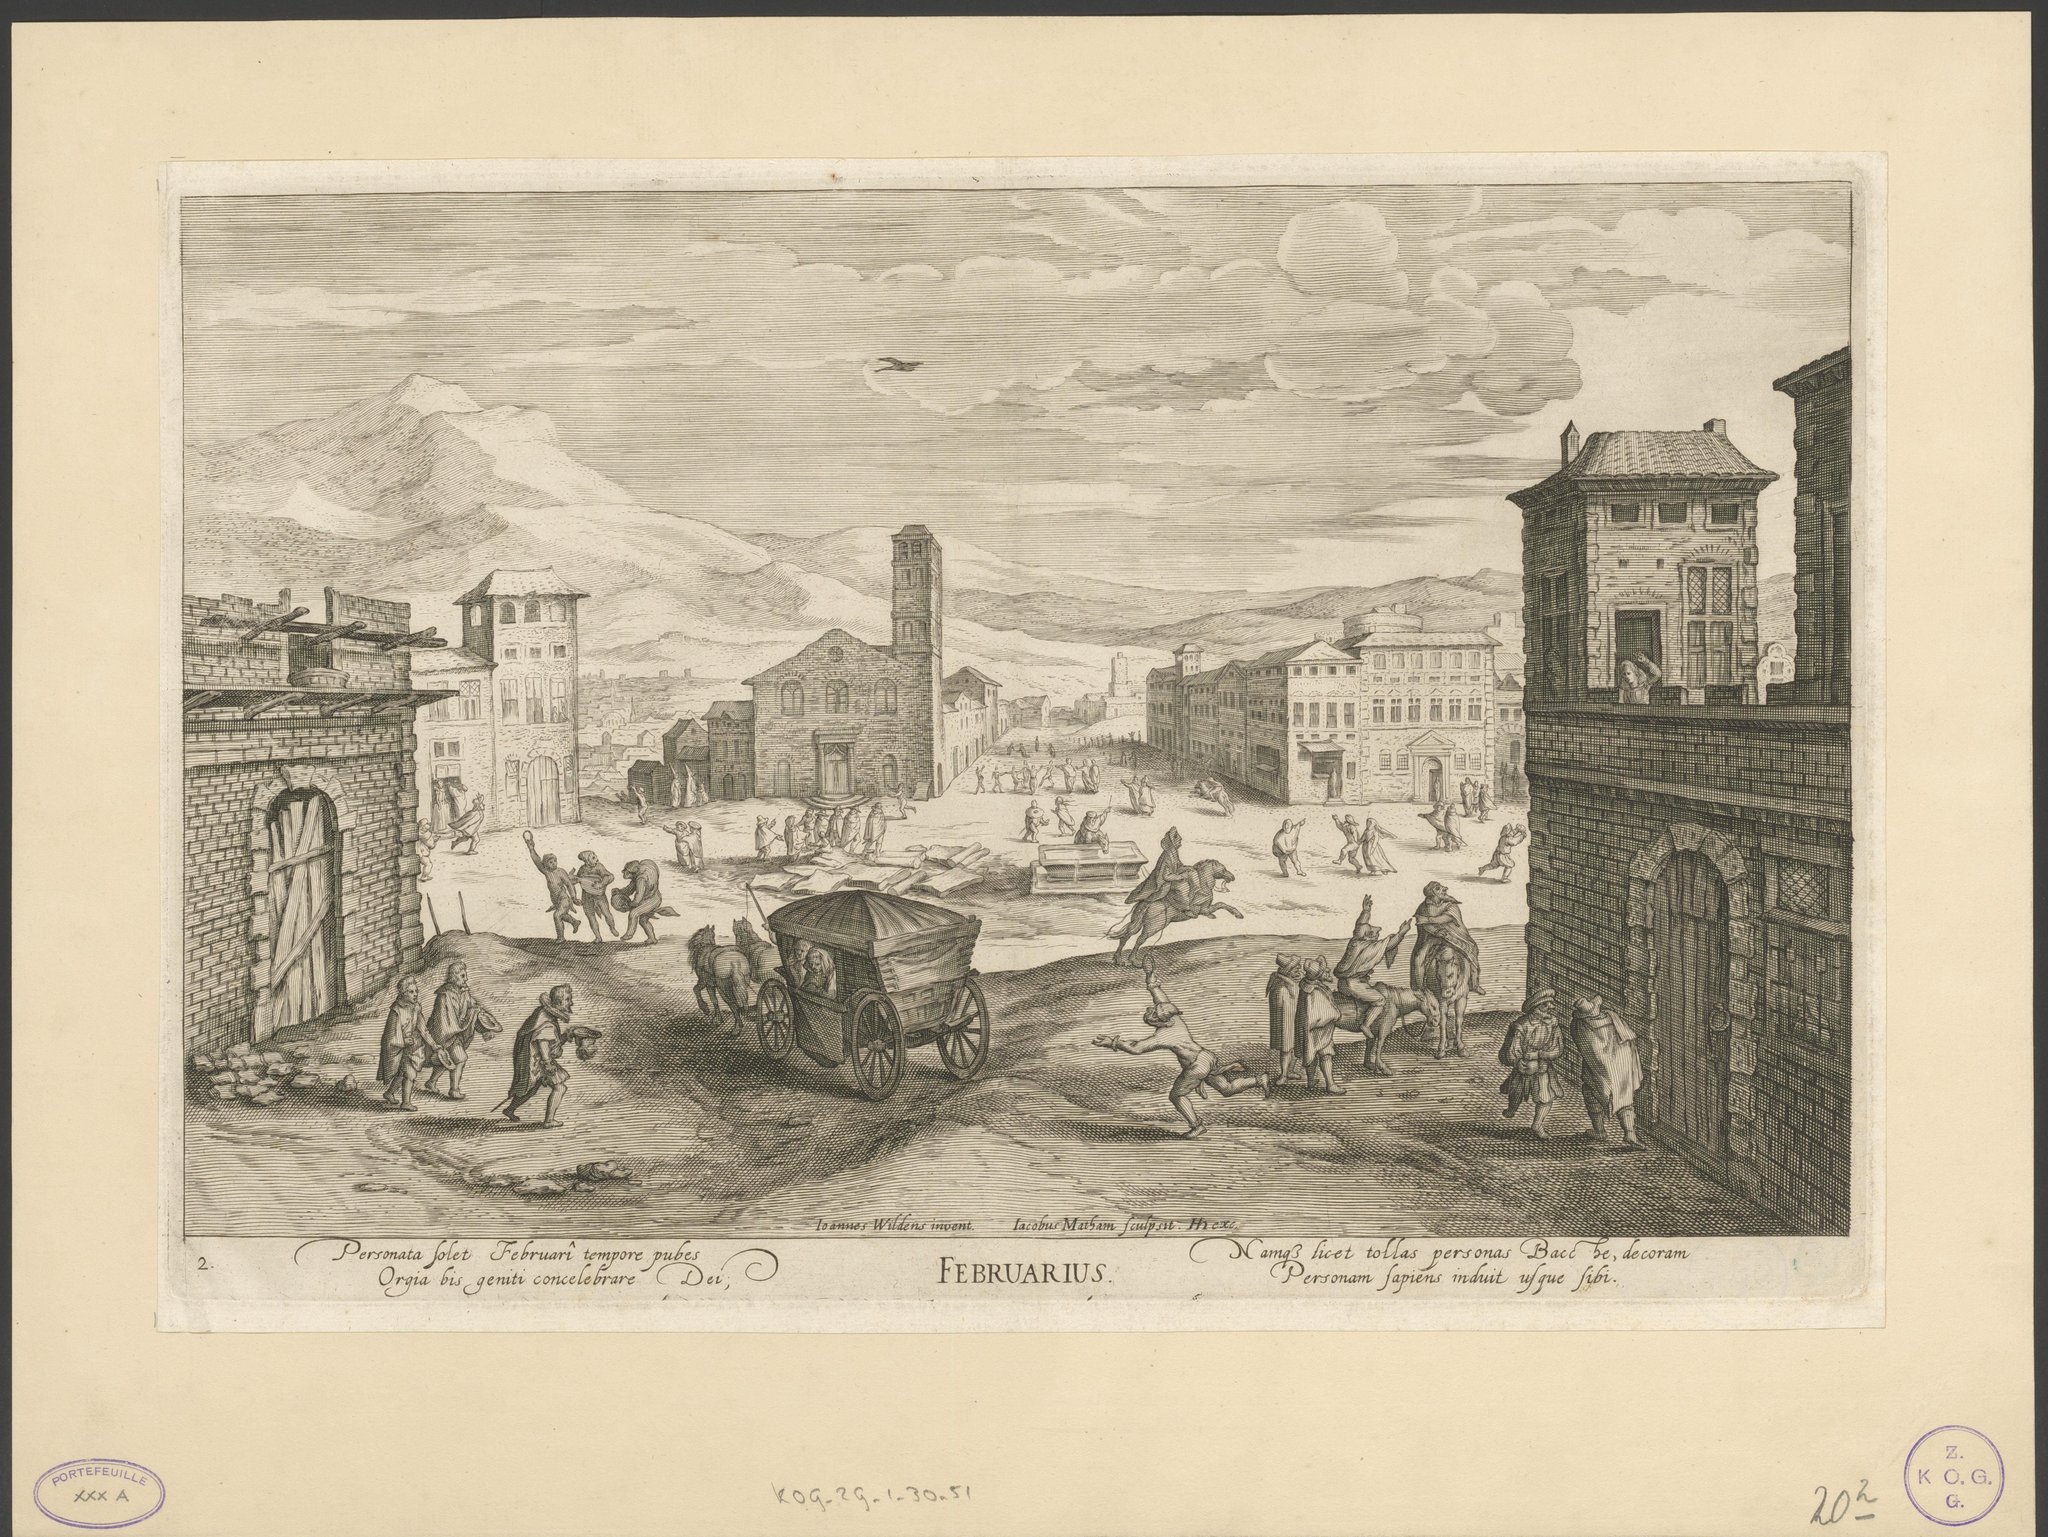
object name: print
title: Februari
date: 1614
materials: paper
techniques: engraving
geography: the hague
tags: landscape symbolizing february, february and its 'labours'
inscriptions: collector's mark: Lugt 1641, stamp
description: Een gezicht op een plein van een stad met vele figuren. Heuvels op de achtergrond. Verbeelding van de maand februari. Onder de voorstelling een tekst in het Latijn. Prent uit een serie van de twaalf maanden. Onderwerpsrubrieken binnen de Atlas Zeden en Gewoonten: Zeden en Gewoonten in engeren zin. Volksleven. Zinnebeeldige voorstellingen uit het volkleven op serieprenten. Maanden en diversen (allegorieën).